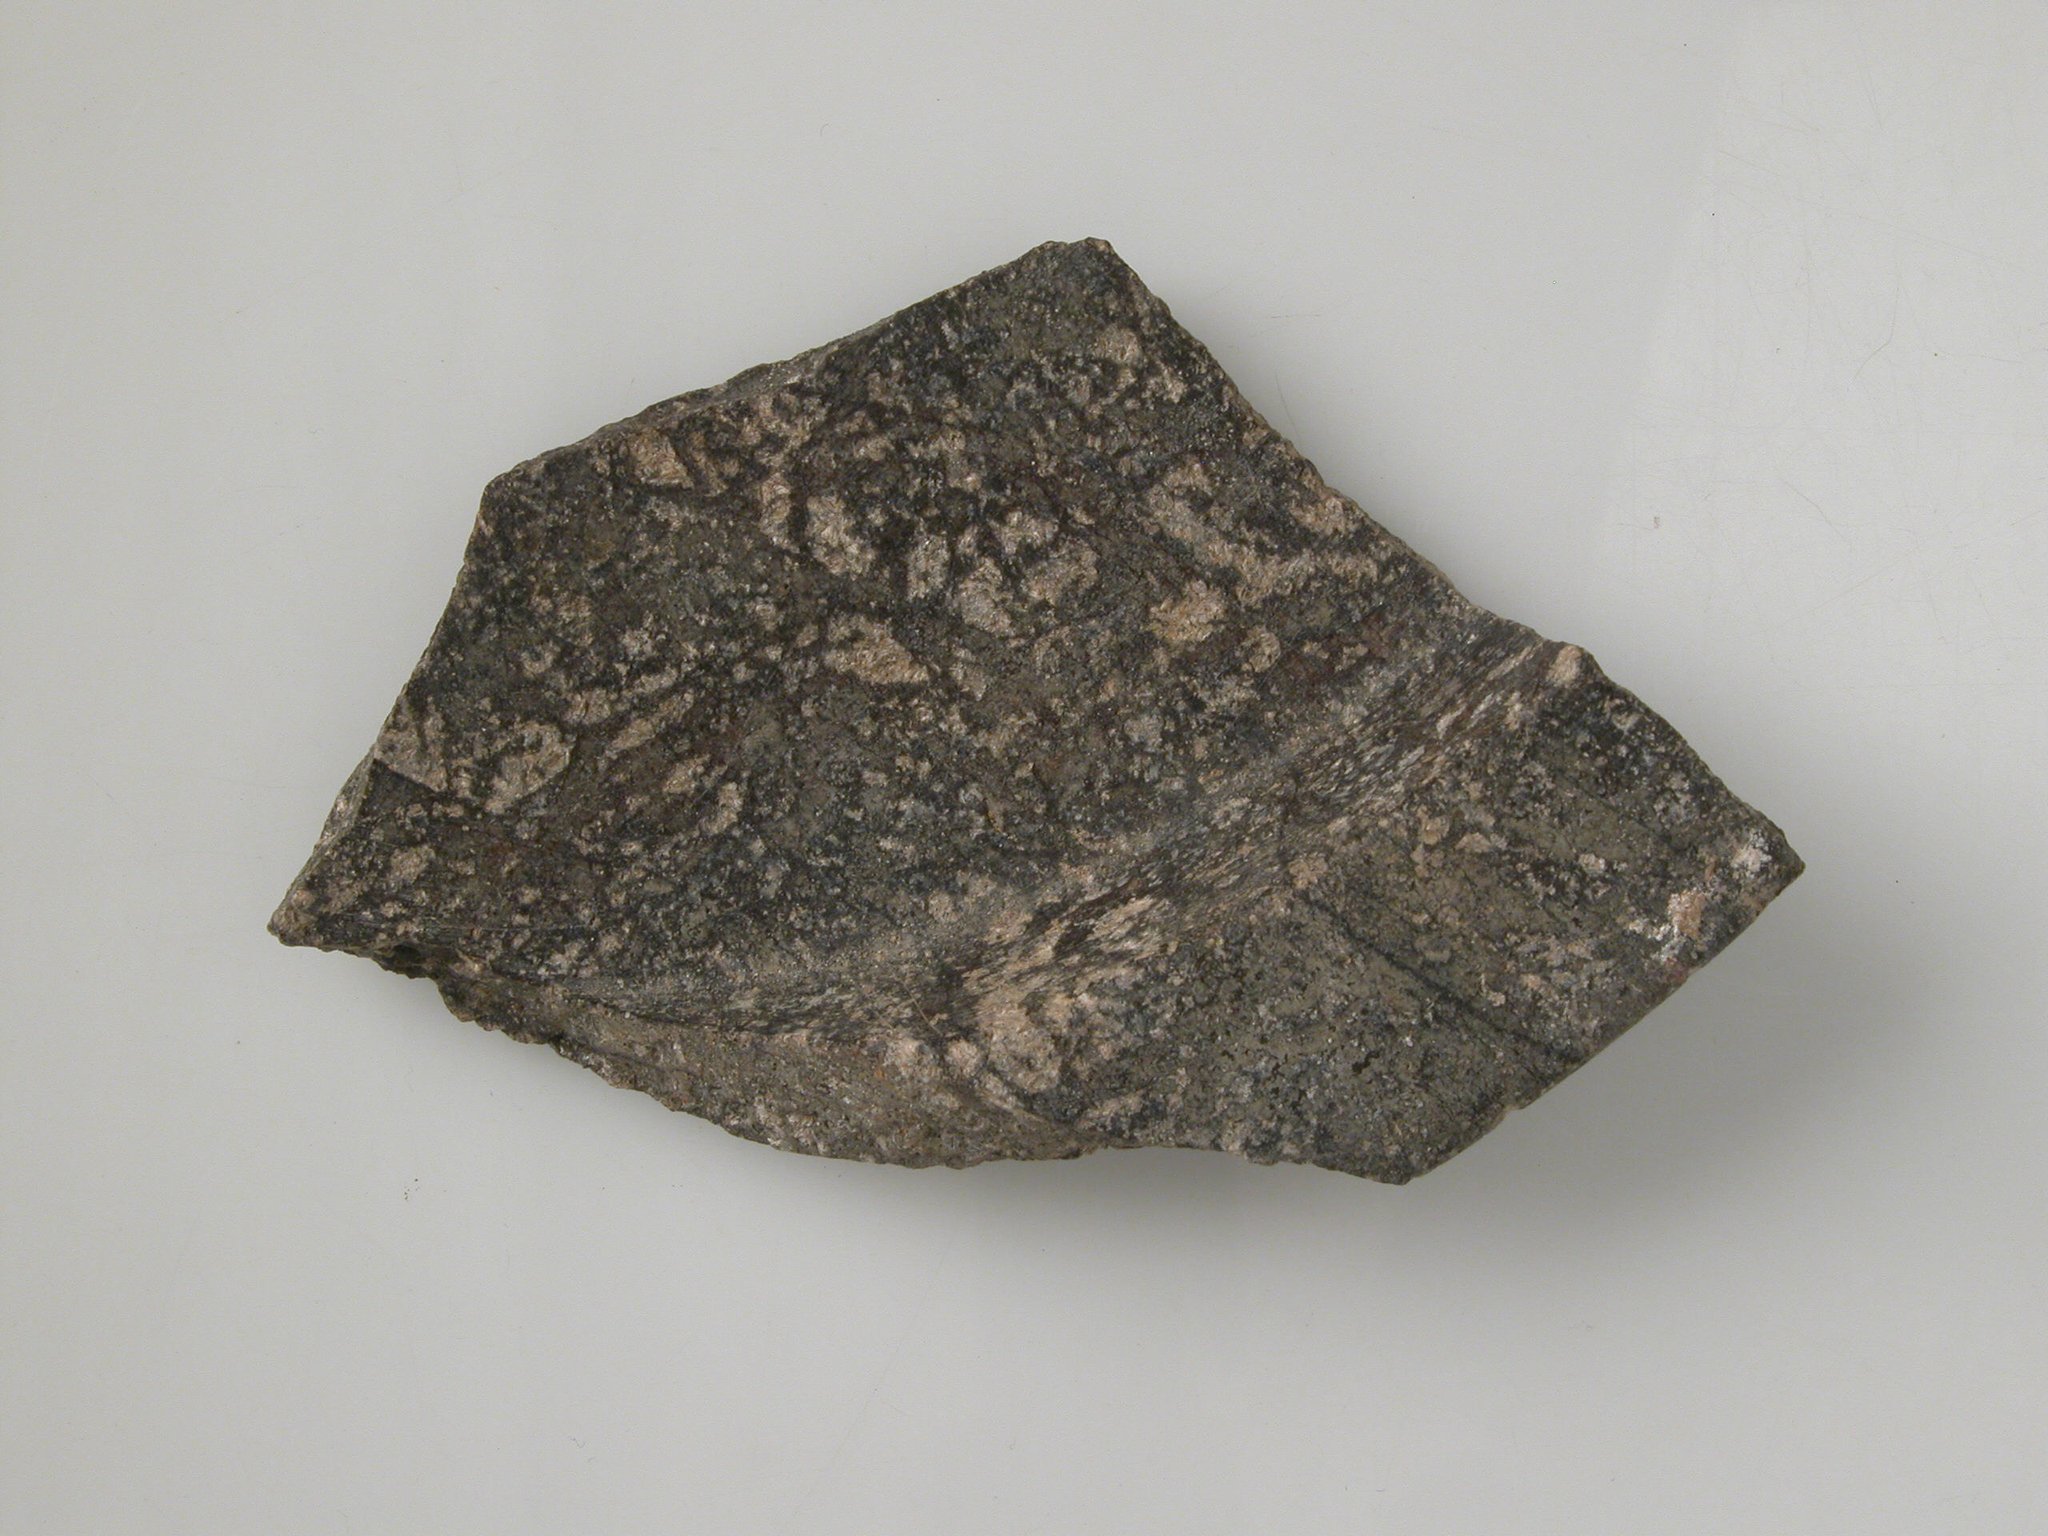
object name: fragment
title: Bowl Fragment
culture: coptic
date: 301-700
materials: stone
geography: egypt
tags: bowls